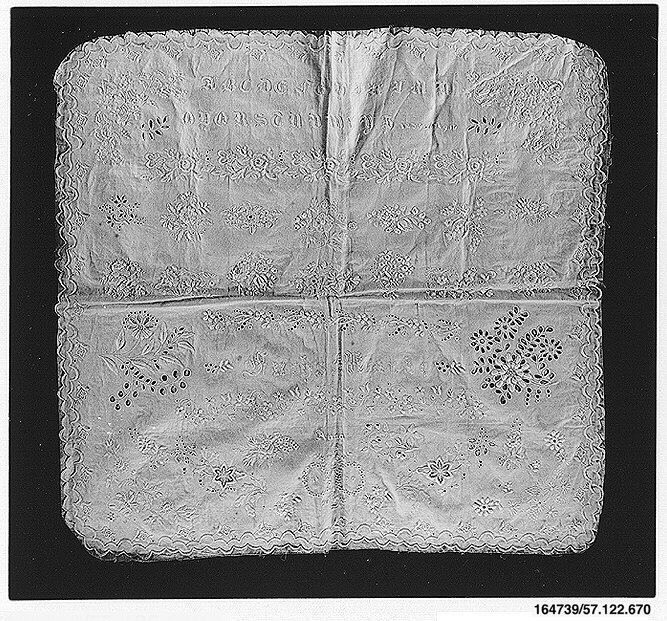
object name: sampler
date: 1860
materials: cotton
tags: flowers